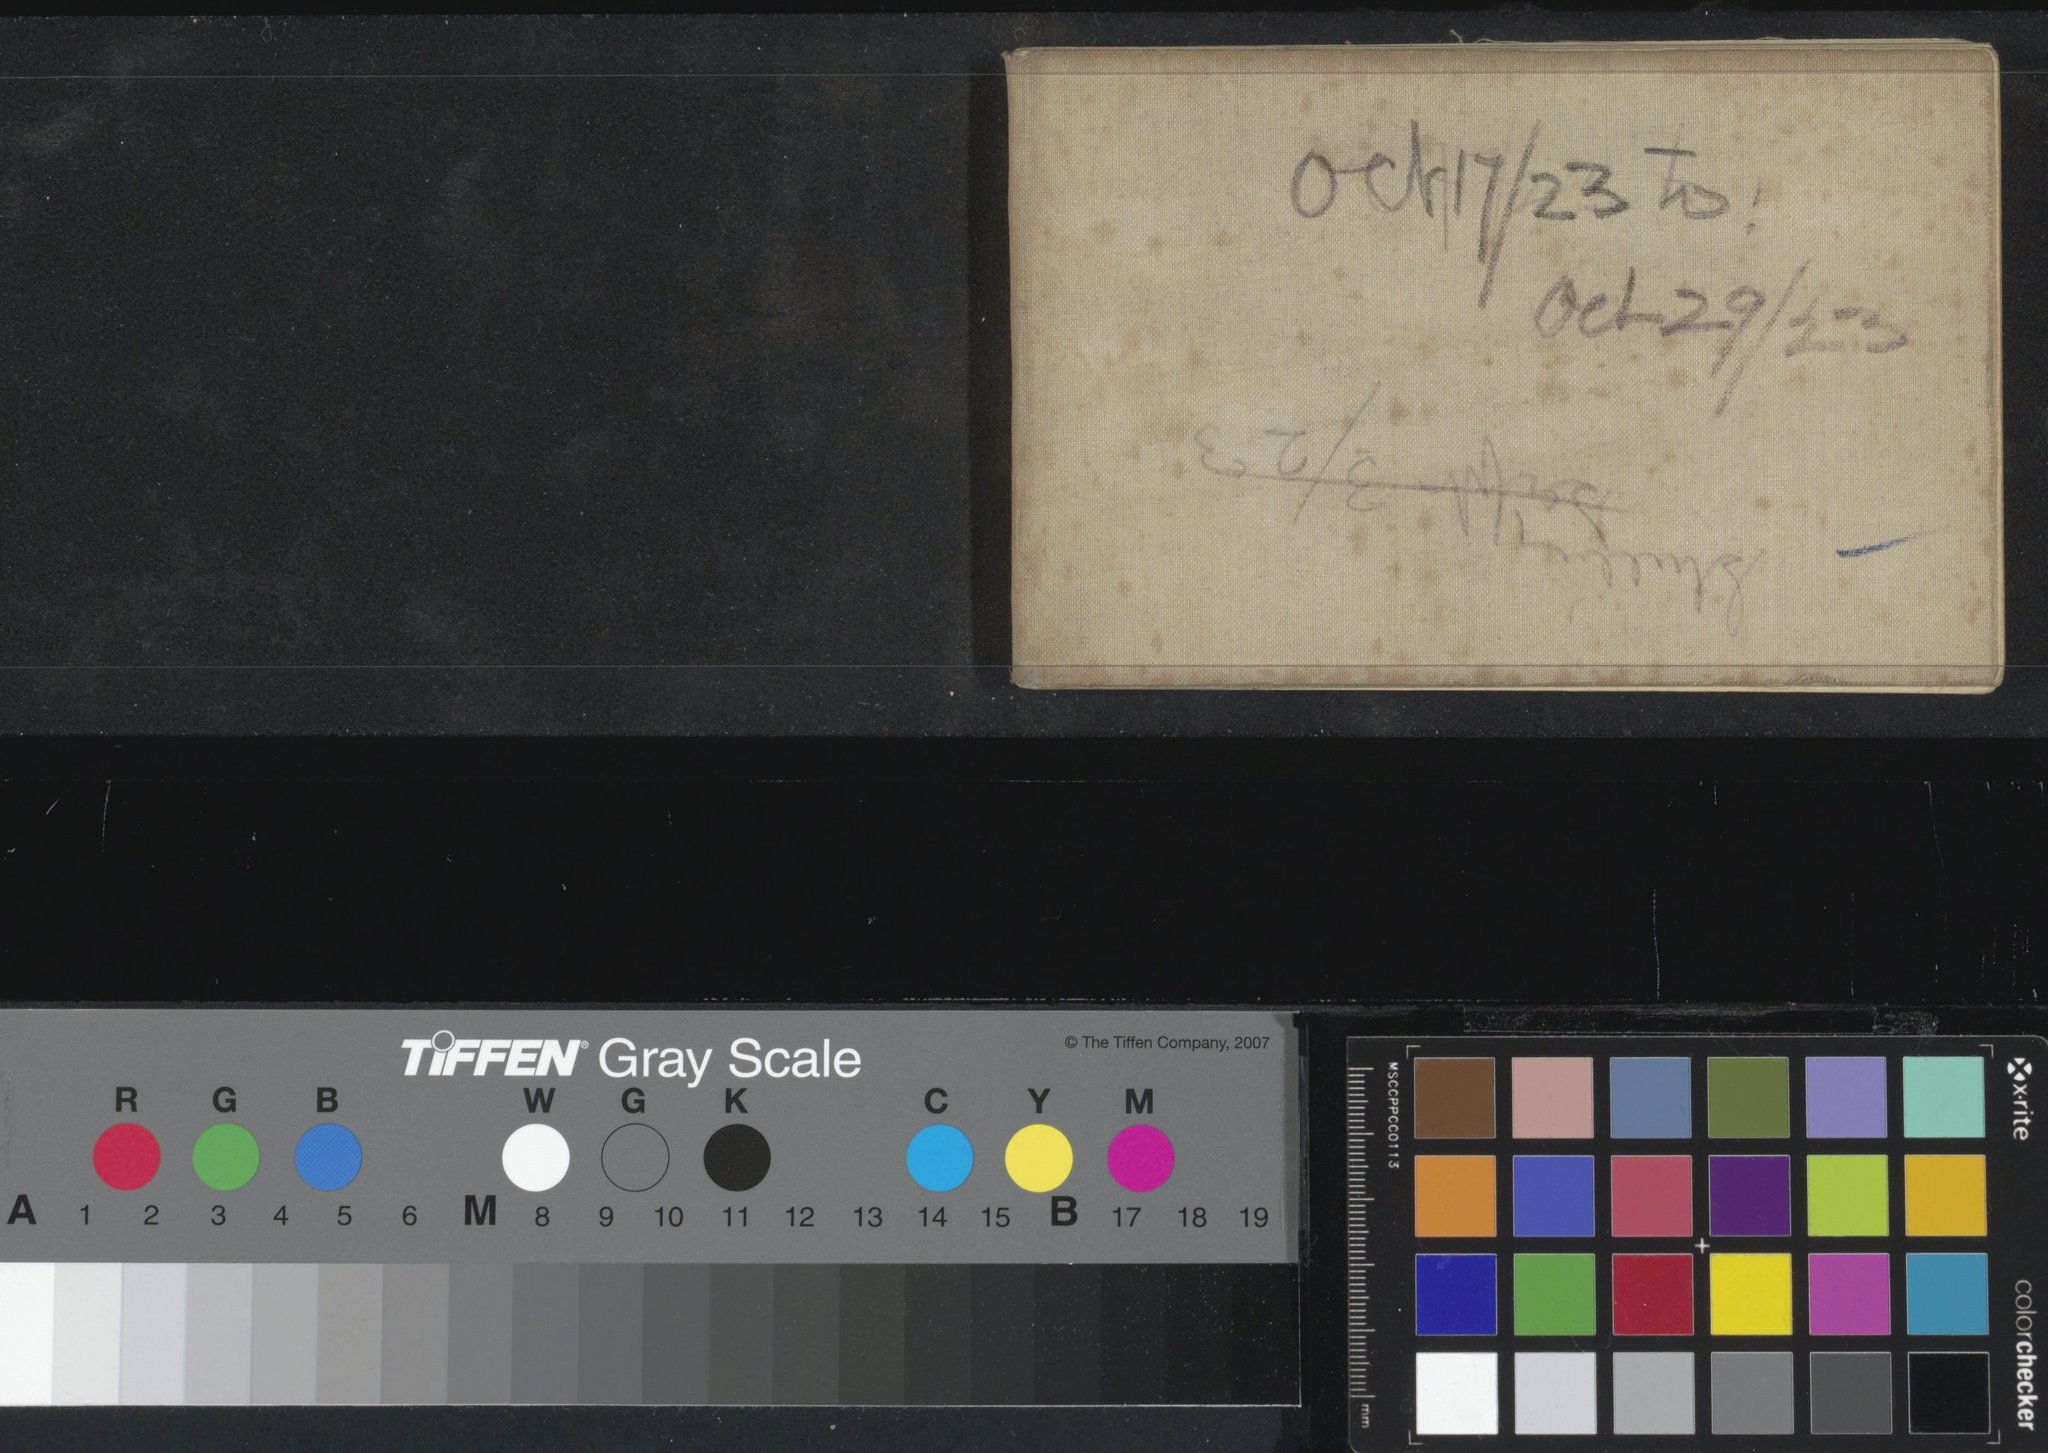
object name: sketchbook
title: Schetsboek met 26 bladen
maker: alexander shilling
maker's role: draughtsman, print maker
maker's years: 1859-1937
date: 1910-1923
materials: chalk, linen, paper, pencil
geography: zeeland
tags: prospect of village, silhouette of village, windmill in landscape, farm or solitary house in landscape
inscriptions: date and inscription: ‘oct 17/23 to:/ oct 29/23/’, date and inscription: ‘Alexander Shilling/ Landschap schetsen uit Damme,/ Walcheren, Veere, Kortgenen/ van 17 Oct tot 29 Oct. 1923’, signature: ‘Shilling/ s[...] 3/23’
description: Schetsboek bestaande uit 26 bladen met landschappen, molens en dorpsgezichten te Damme, Veere en Kortgene.